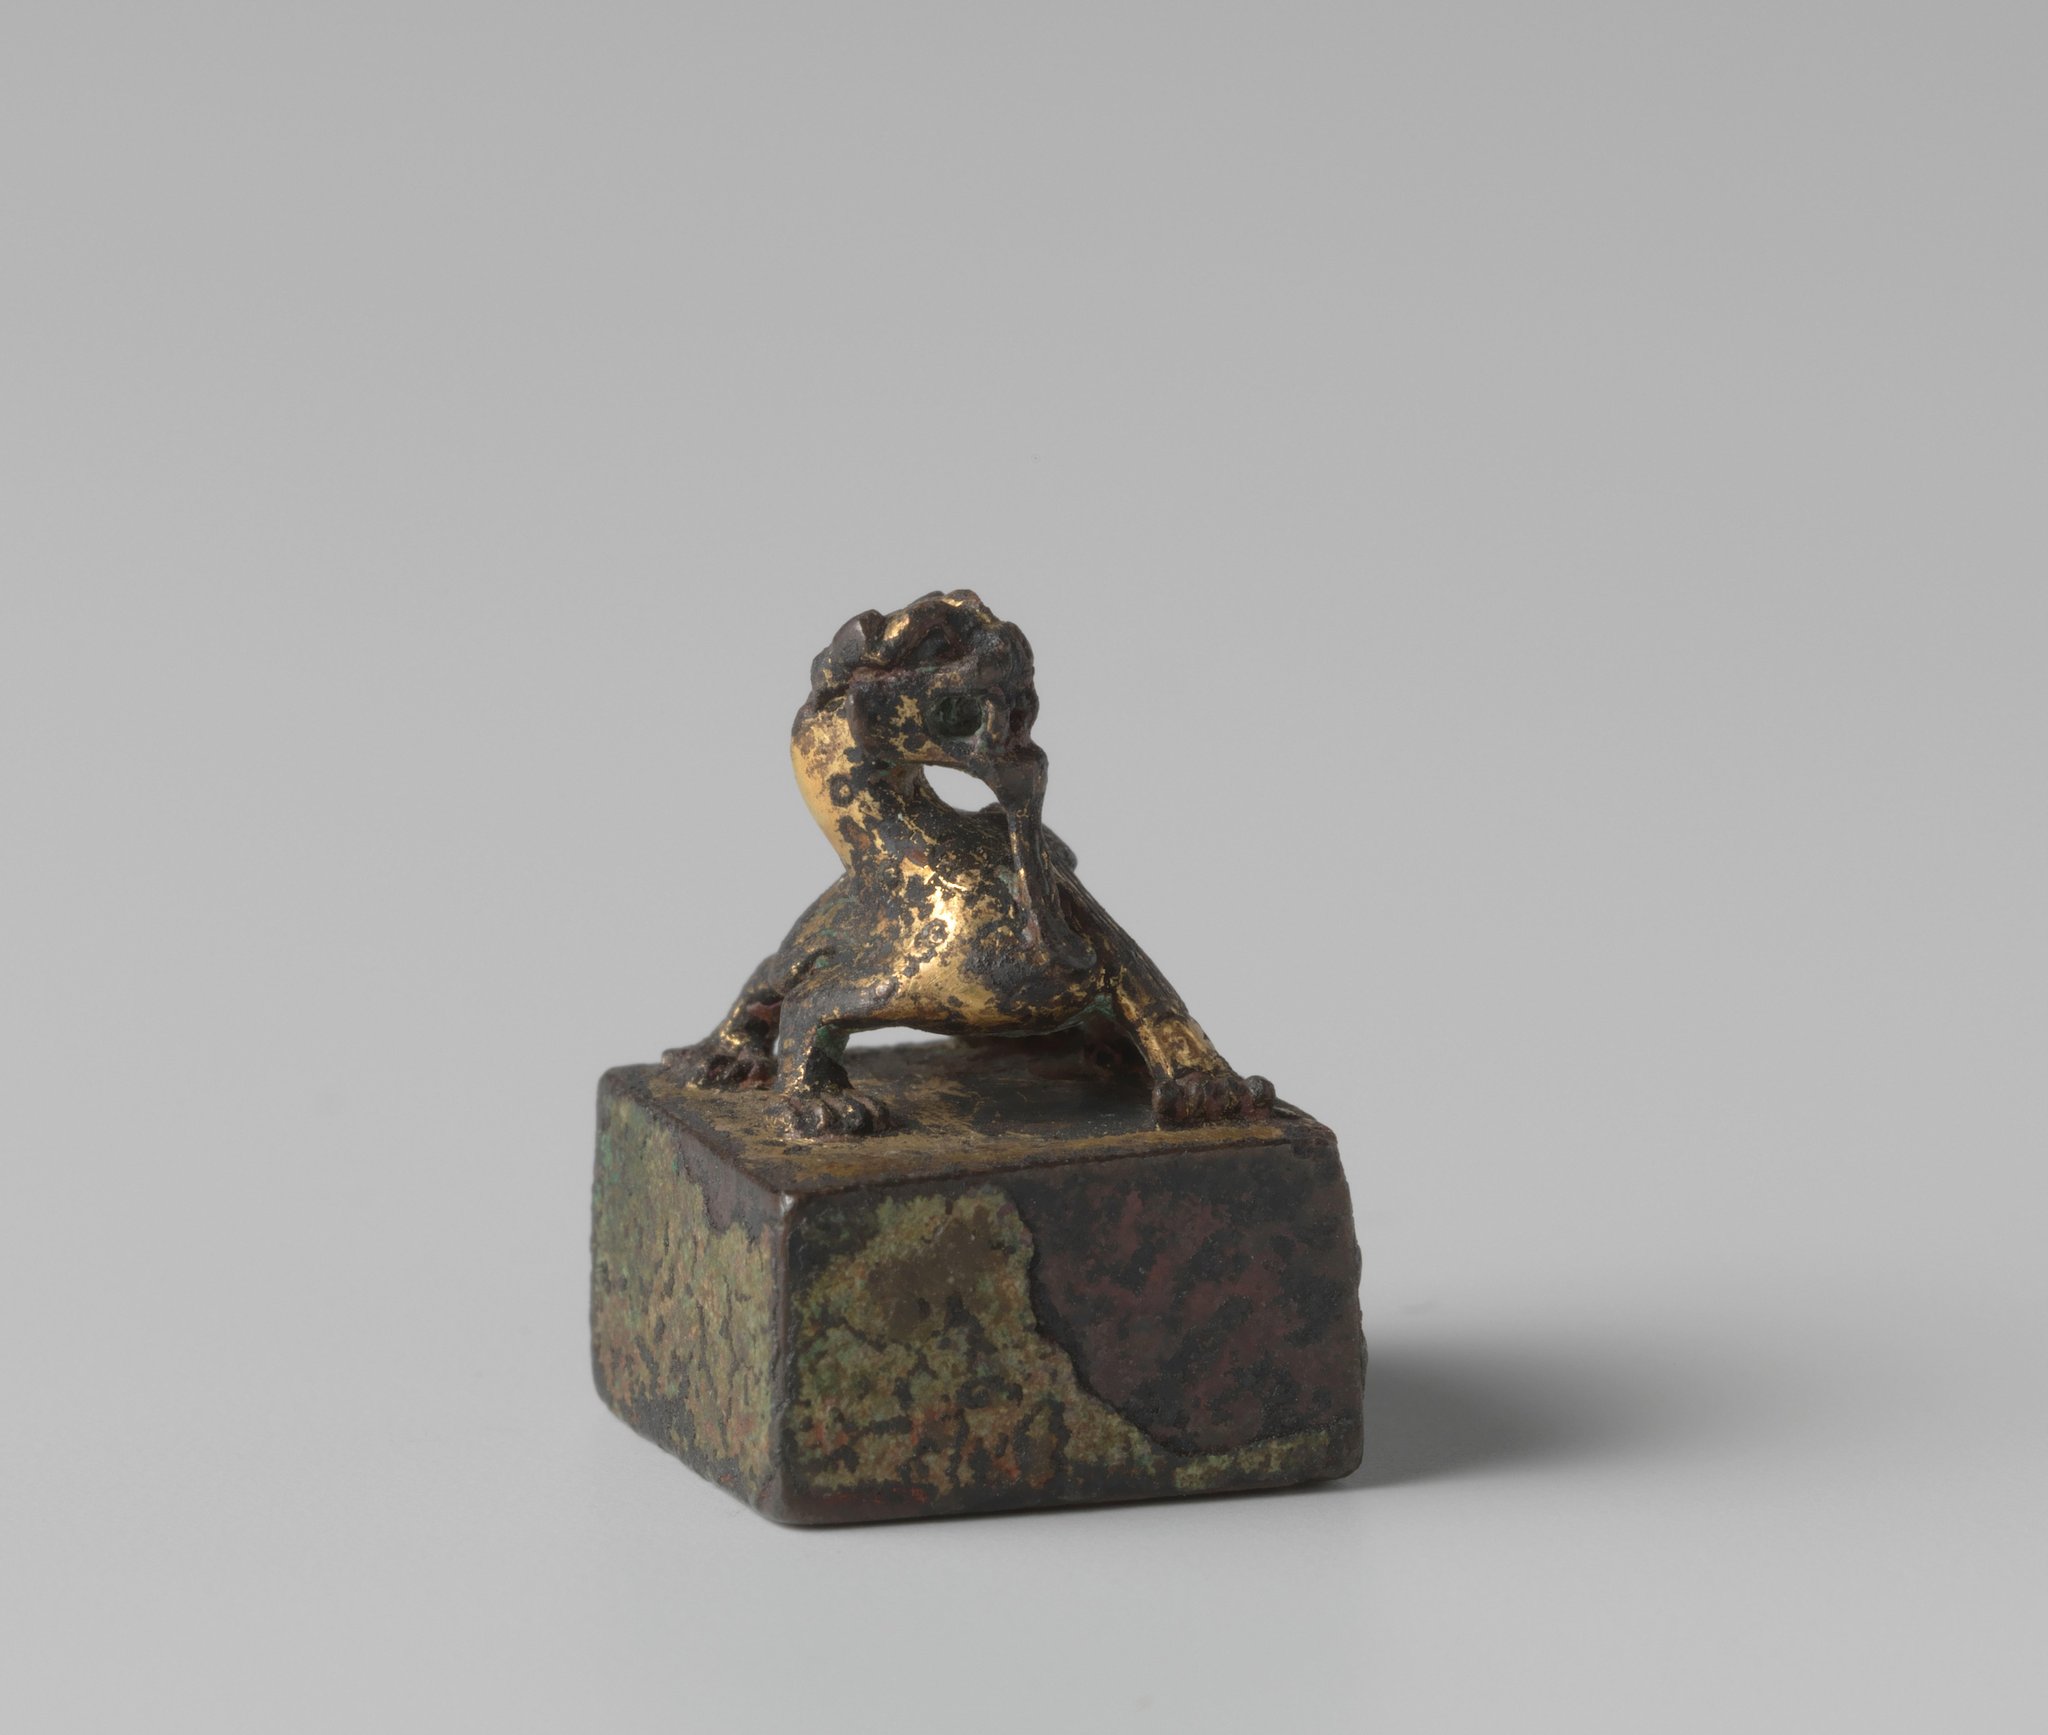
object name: zegelstempel, lakstempel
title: Zegelstempel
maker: Anonymous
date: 300-500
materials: bronze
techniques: gilding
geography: china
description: Seal, crowned with a winged lion. China. Northern and Southern dynasties period (256 - 589), 4th - 5th century. Bronze gilt. The text on the underside reads: Seal belonging to Mao Kuang.